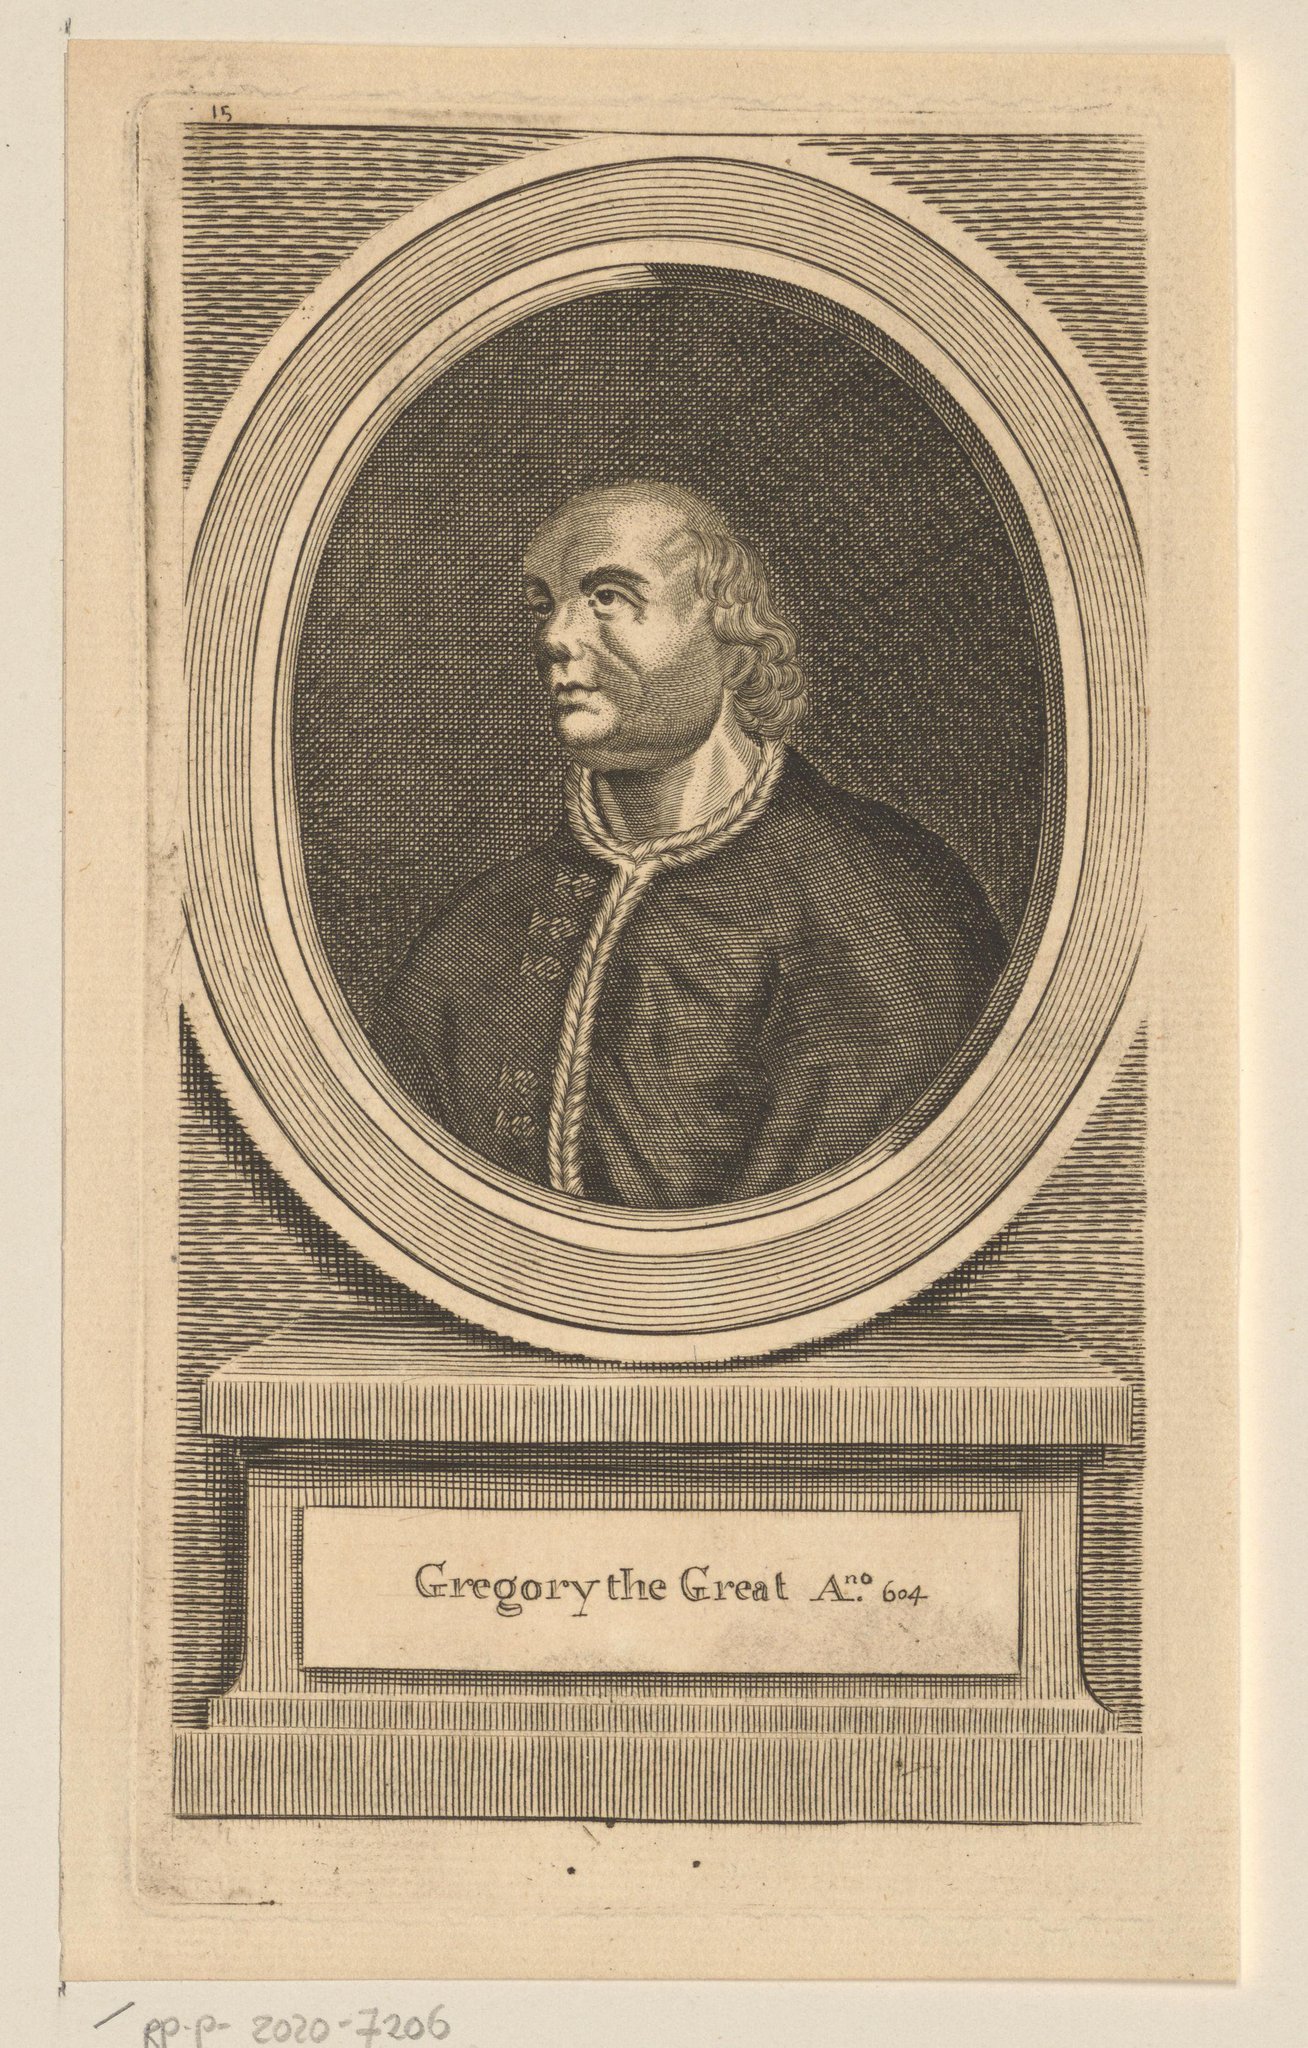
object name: print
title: Portret van paus Gregorius I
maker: Anonymous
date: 1650-1750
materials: paper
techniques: engraving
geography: great britain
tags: historical persons, pope